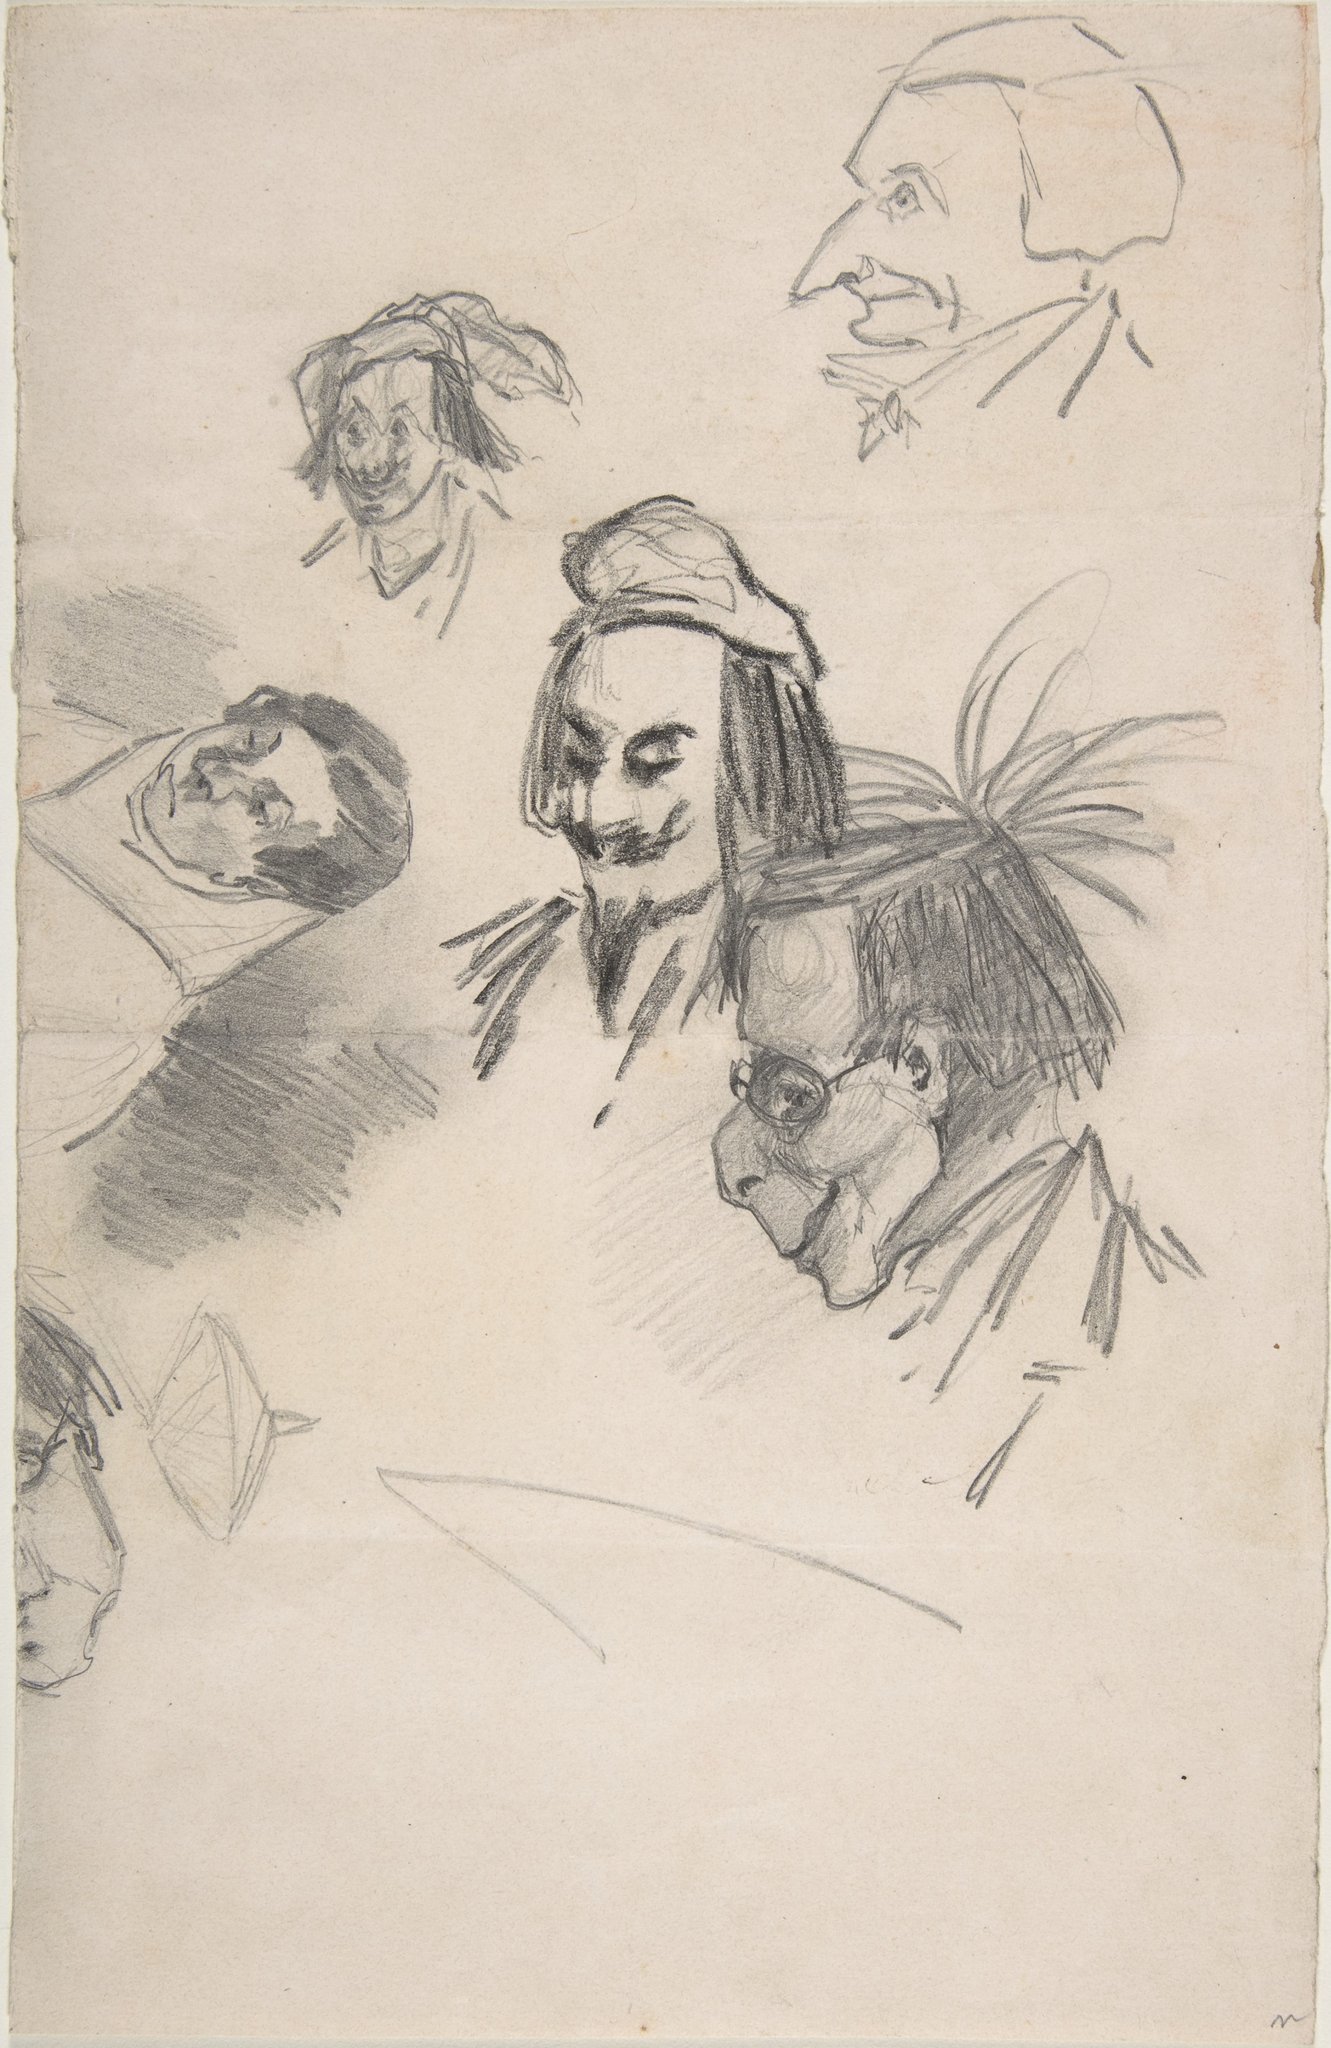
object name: drawing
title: Sketches of Six Heads in Profile (caricatures?) (recto); Sketch of Head and Blank Rectangle (verso)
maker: félicien rops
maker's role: artist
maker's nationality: belgian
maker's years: 1833-1898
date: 1833-1898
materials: chalk, graphite, paper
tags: heads,men,portraits,profiles